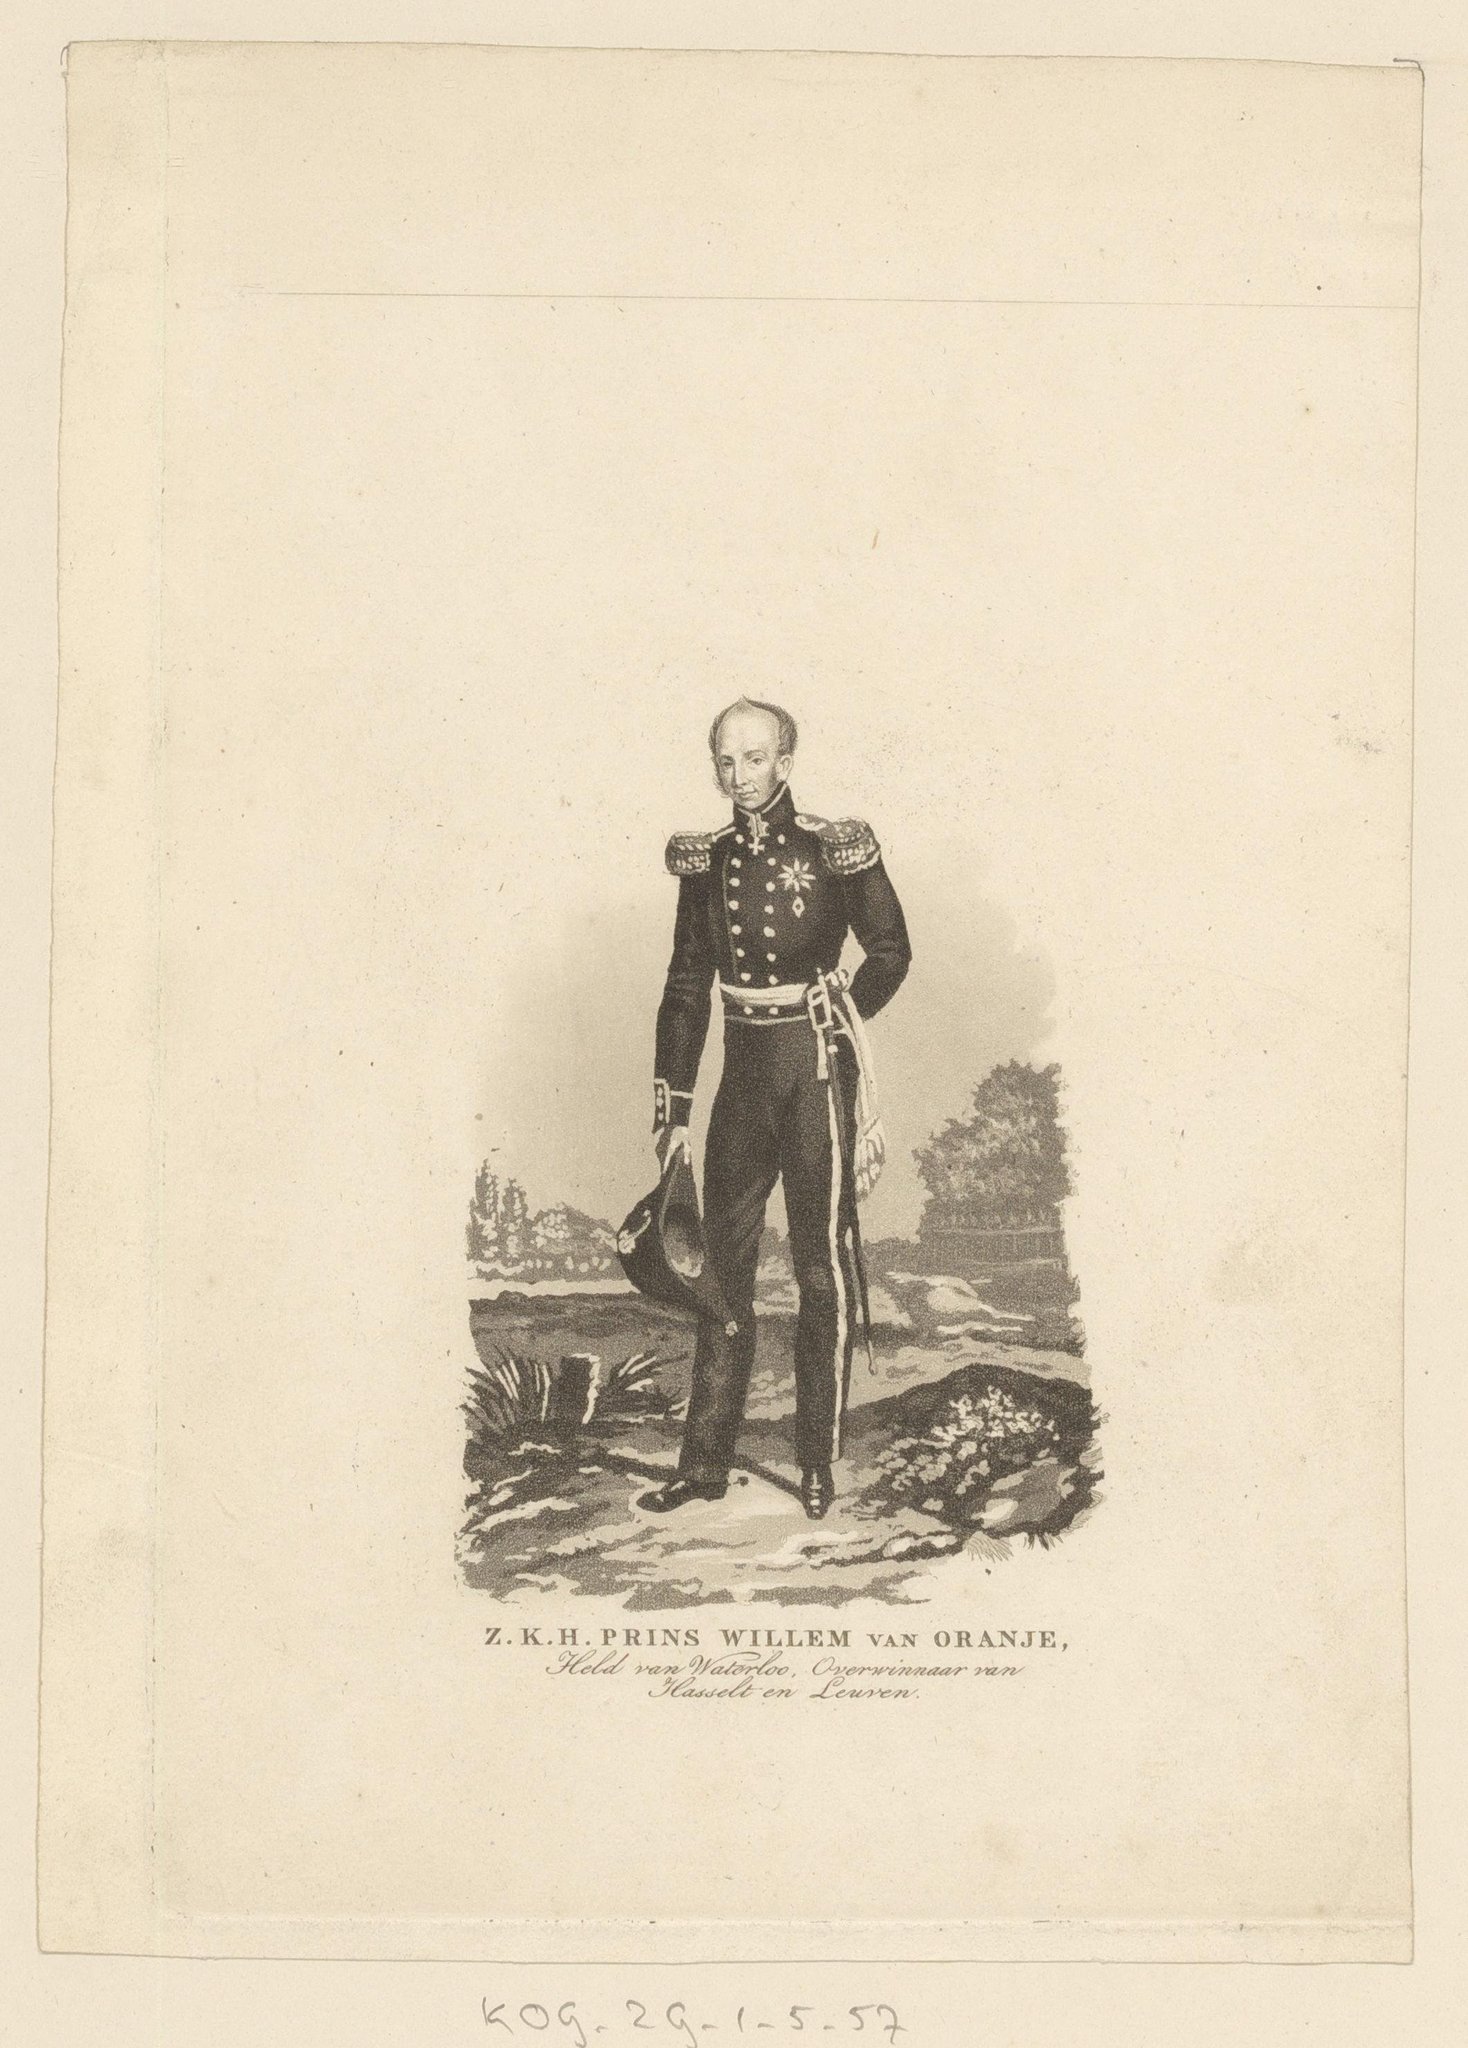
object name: print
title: Portret van Willem II, koning der Nederlanden, dan nog prins van Oranje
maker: Anonymous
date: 1832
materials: paper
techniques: aquatint, engraving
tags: the hague, william ii of the netherlands, the soldier; the soldier's life, antwerp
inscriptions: stamp, stamp, collector's mark: Lugt 1641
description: Prent mogelijk uit: Beschrijving der gebeurtenissen, voorgevallen te Antwerpen. Amsterdam: A. Feteris en A. Pieterse, ca. 1832.